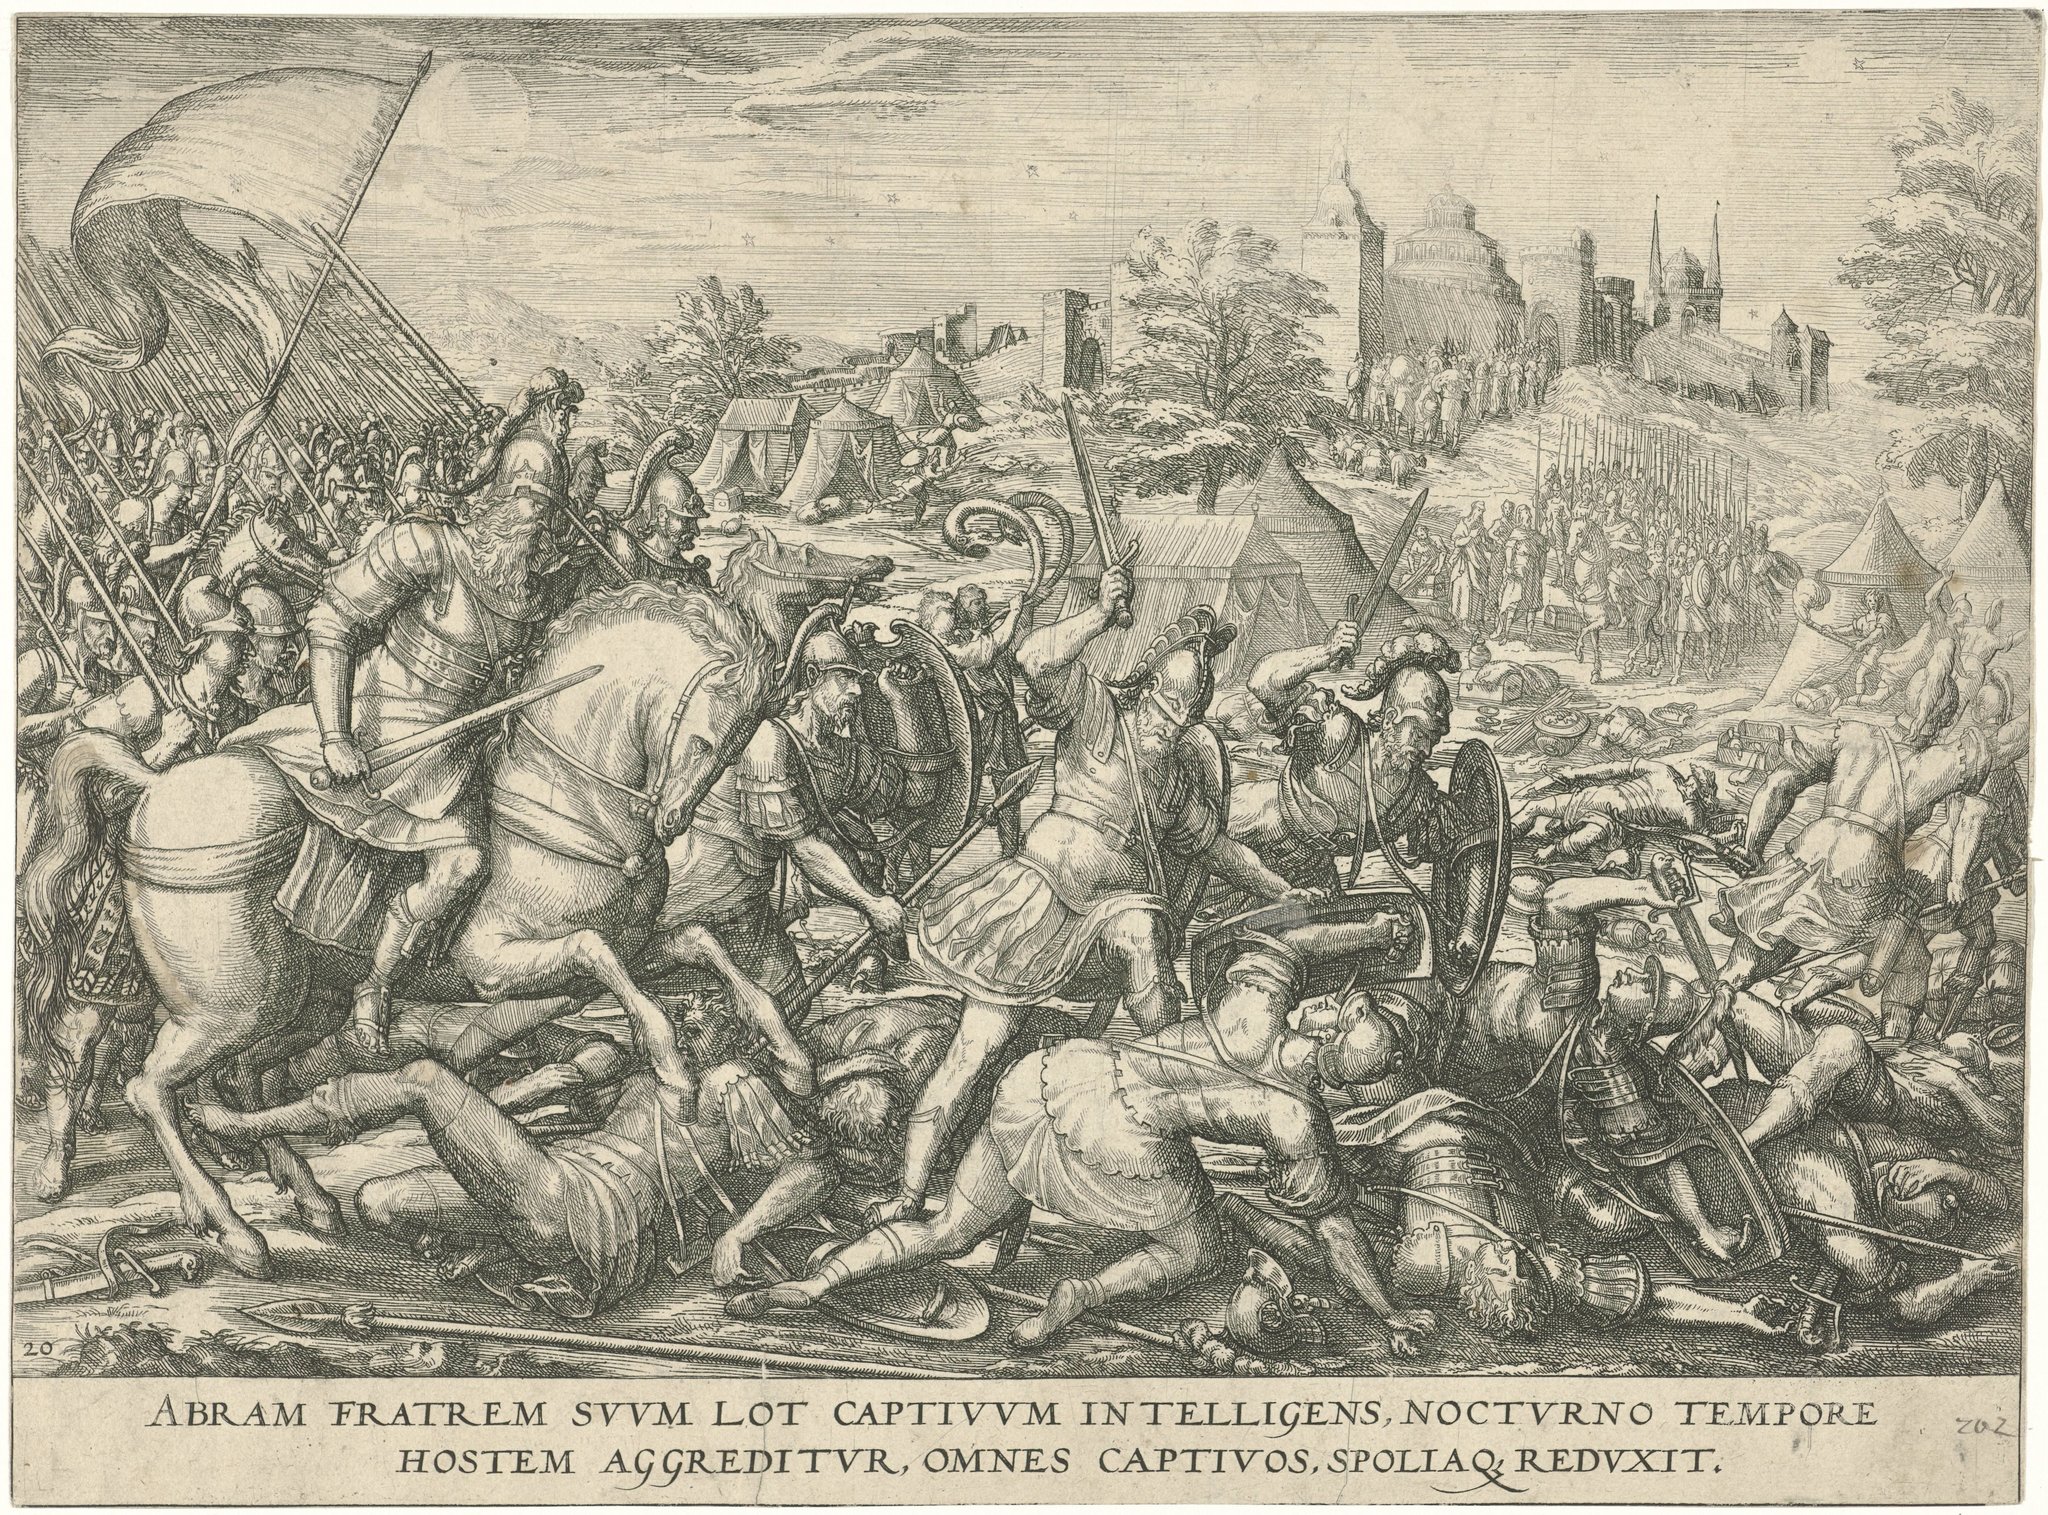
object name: print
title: Abraham bevrijdt Lot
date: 1577-1627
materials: paper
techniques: etching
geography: cologne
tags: sodom and gomorrah are plundered; lot is taken into captivity, the four kings are attacked at night, and defeated by abraham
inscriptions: collector's mark: Lugt 2228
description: Abraham, links te paard gezeten, valt 's nachts met zijn mannen het leger van koning Kedorlaomer en diens bondgenoten aan om zijn neef Lot te bevrijden. Rechtsachter worden Lot en de zijnen door de vijand uit Sodom weggevoerd. Onderaan een verwijzing in het Latijn naar de Bijbeltekst in Gen. 14.